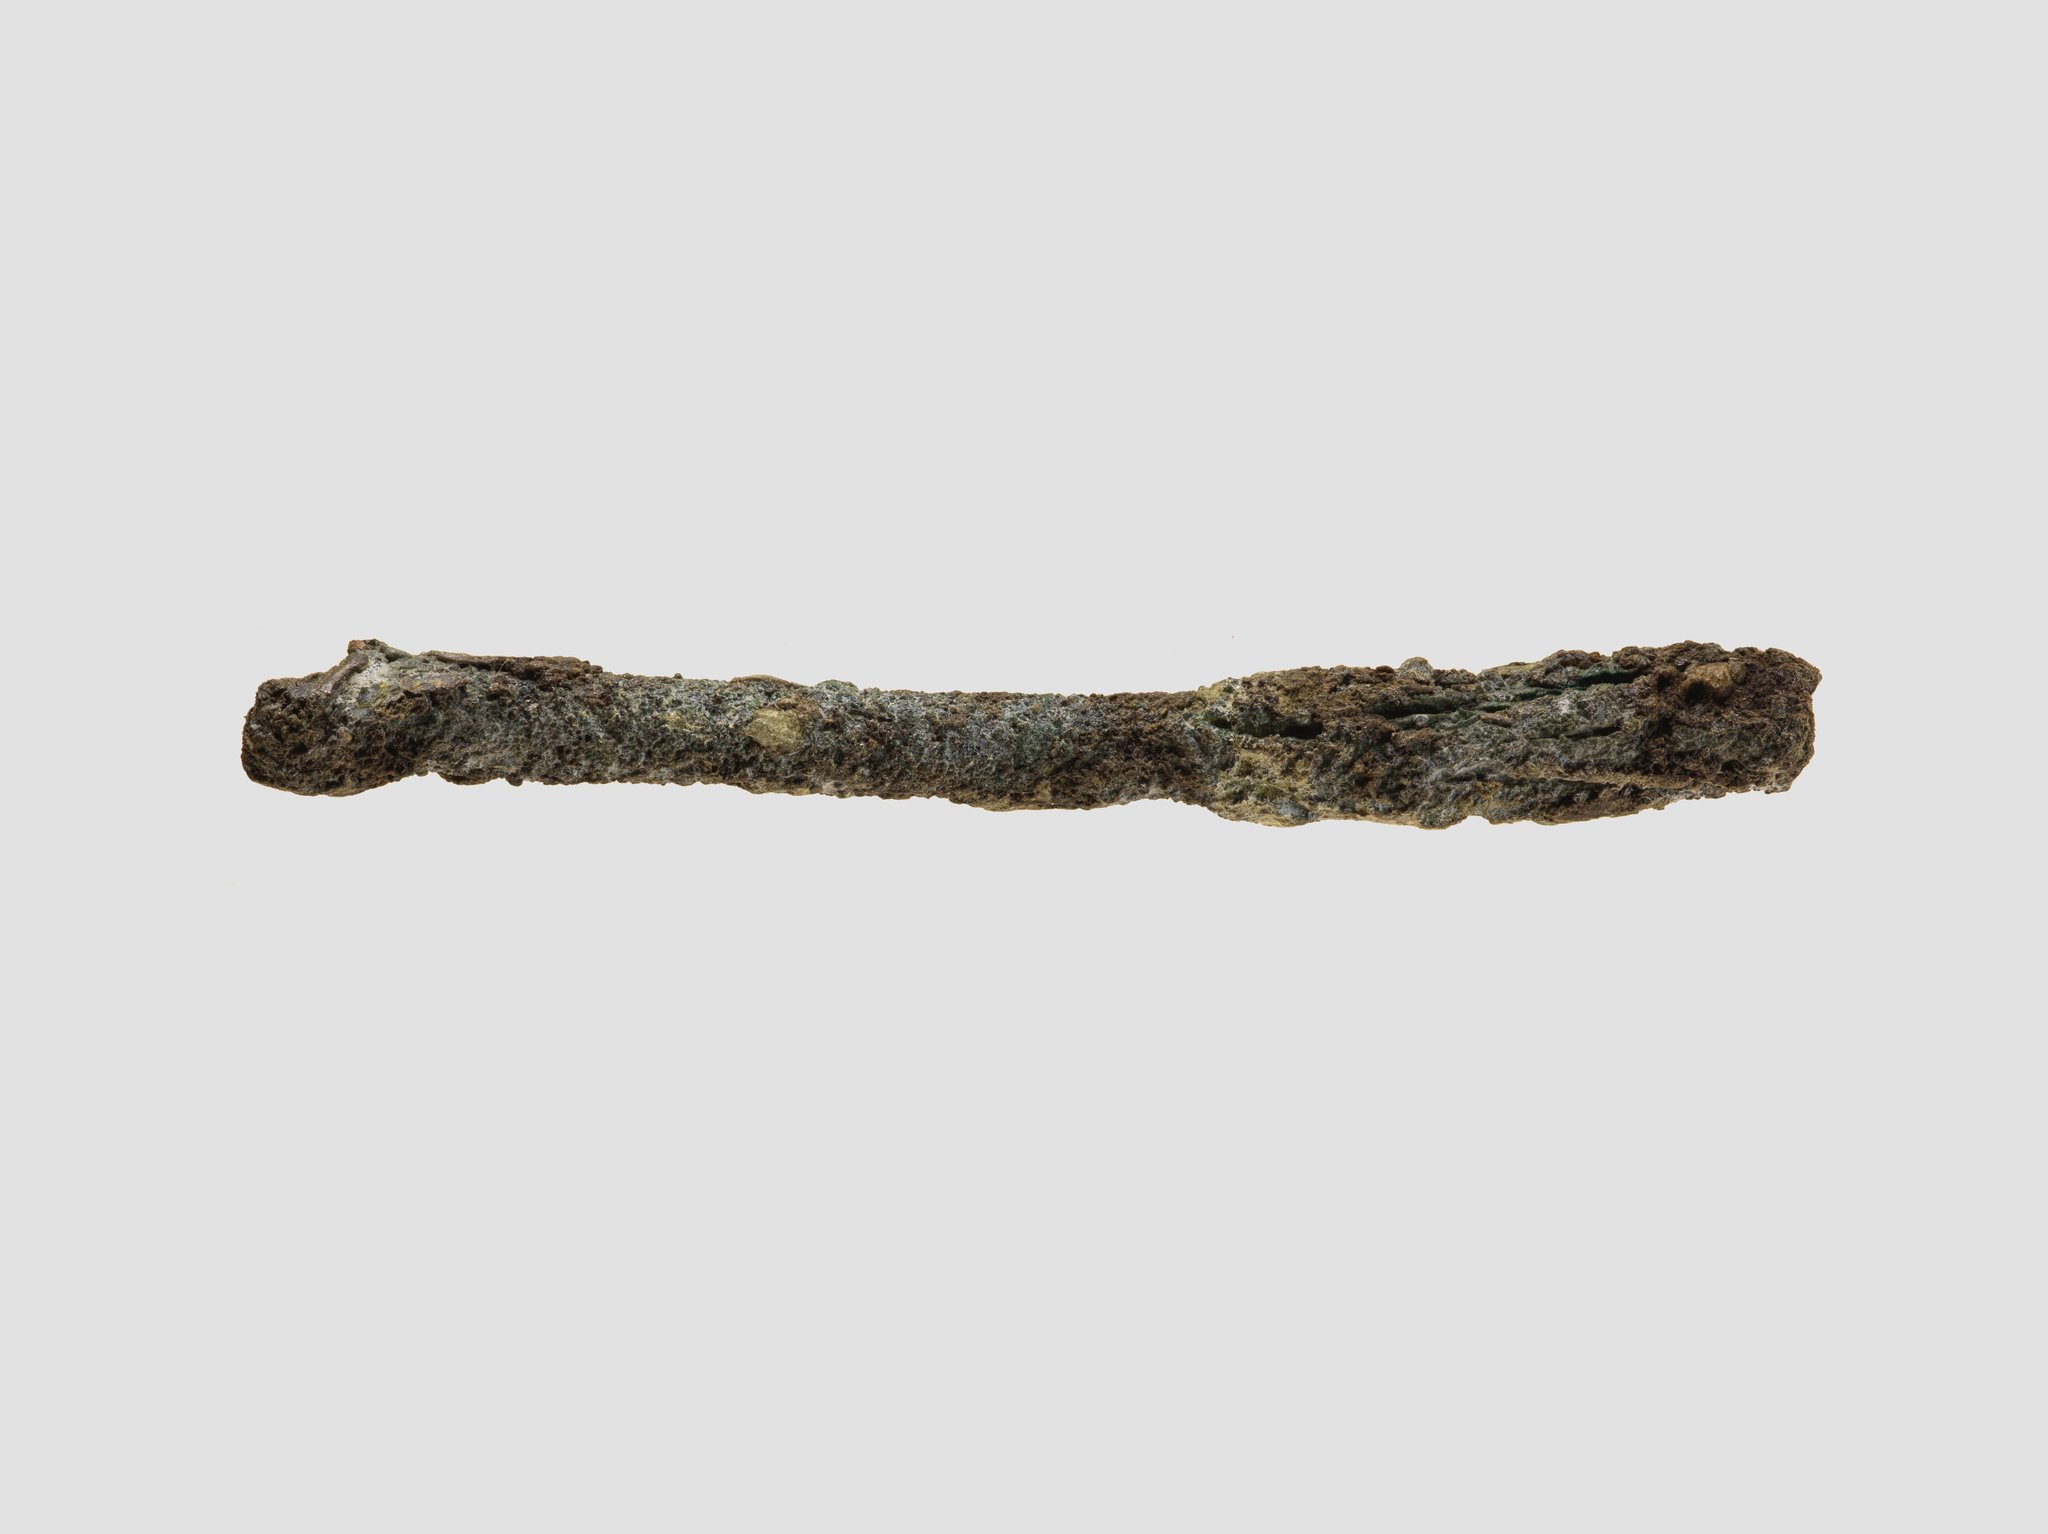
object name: pin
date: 1780-1580 BCE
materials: bronze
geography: levant